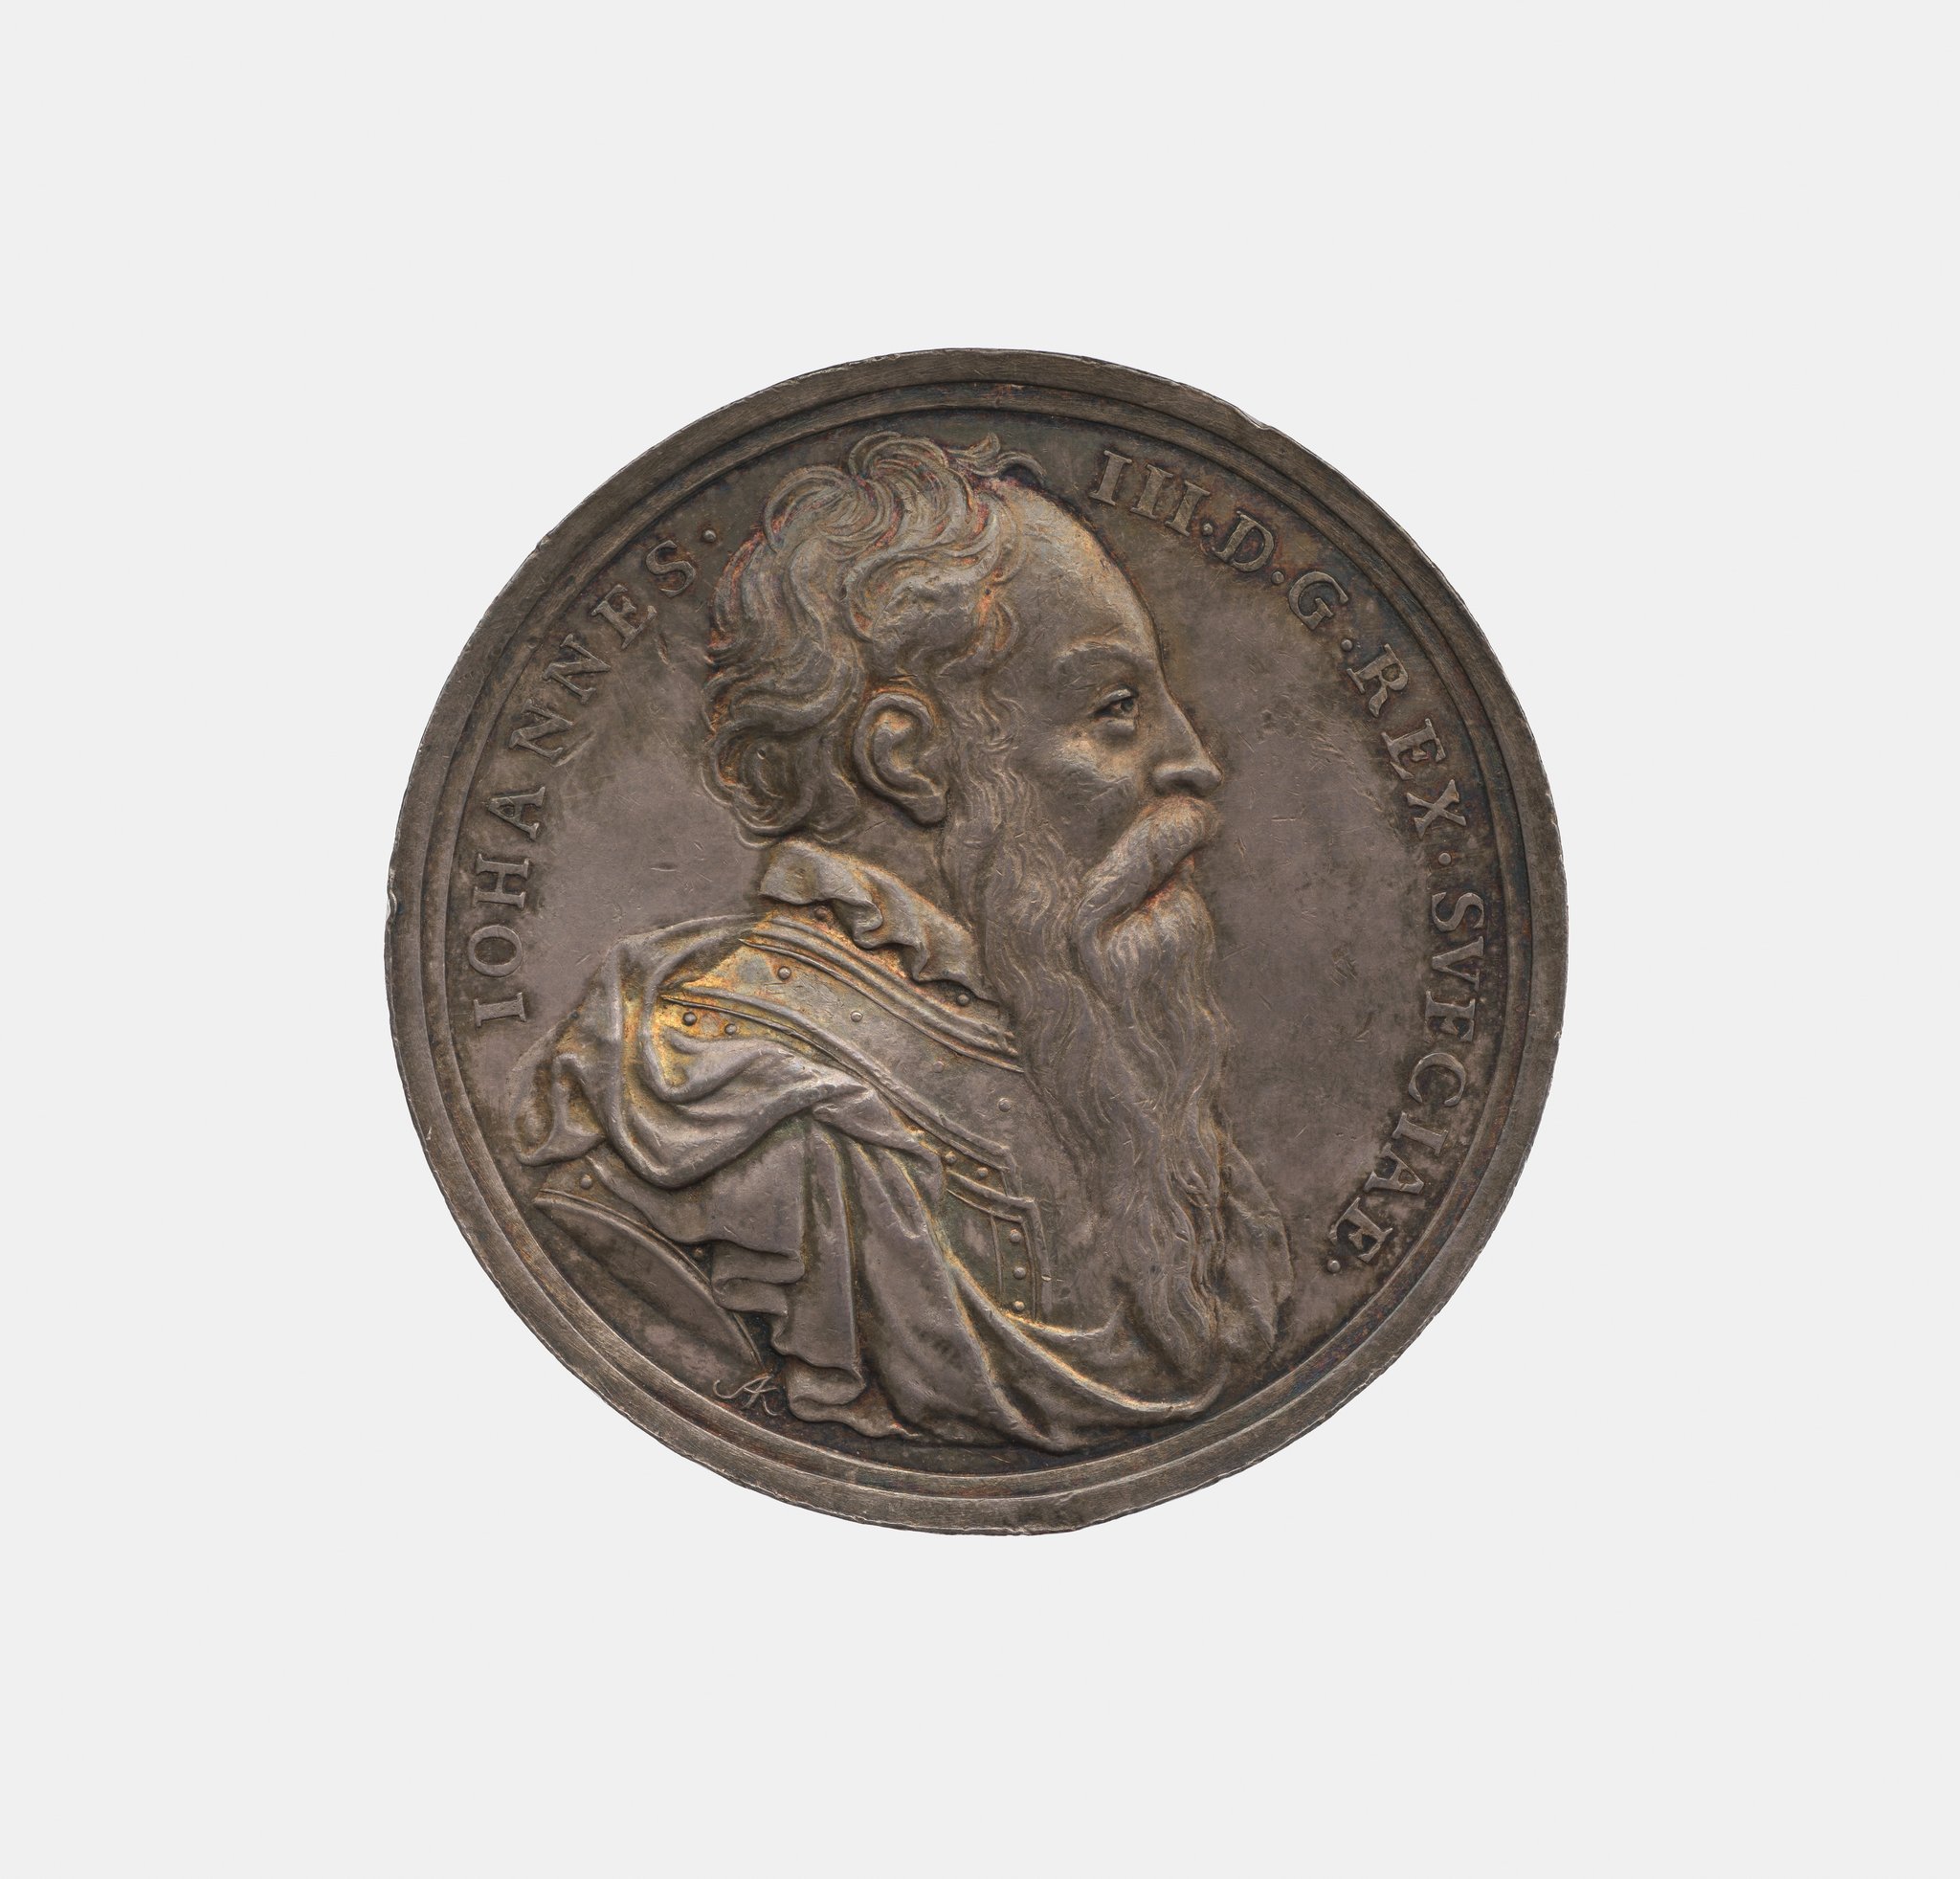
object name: medal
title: Johan III, King of Sweden (r. 1569–1592)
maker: arfvid karlsteen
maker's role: artist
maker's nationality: swedish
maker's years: 1654-1718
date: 1700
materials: silver